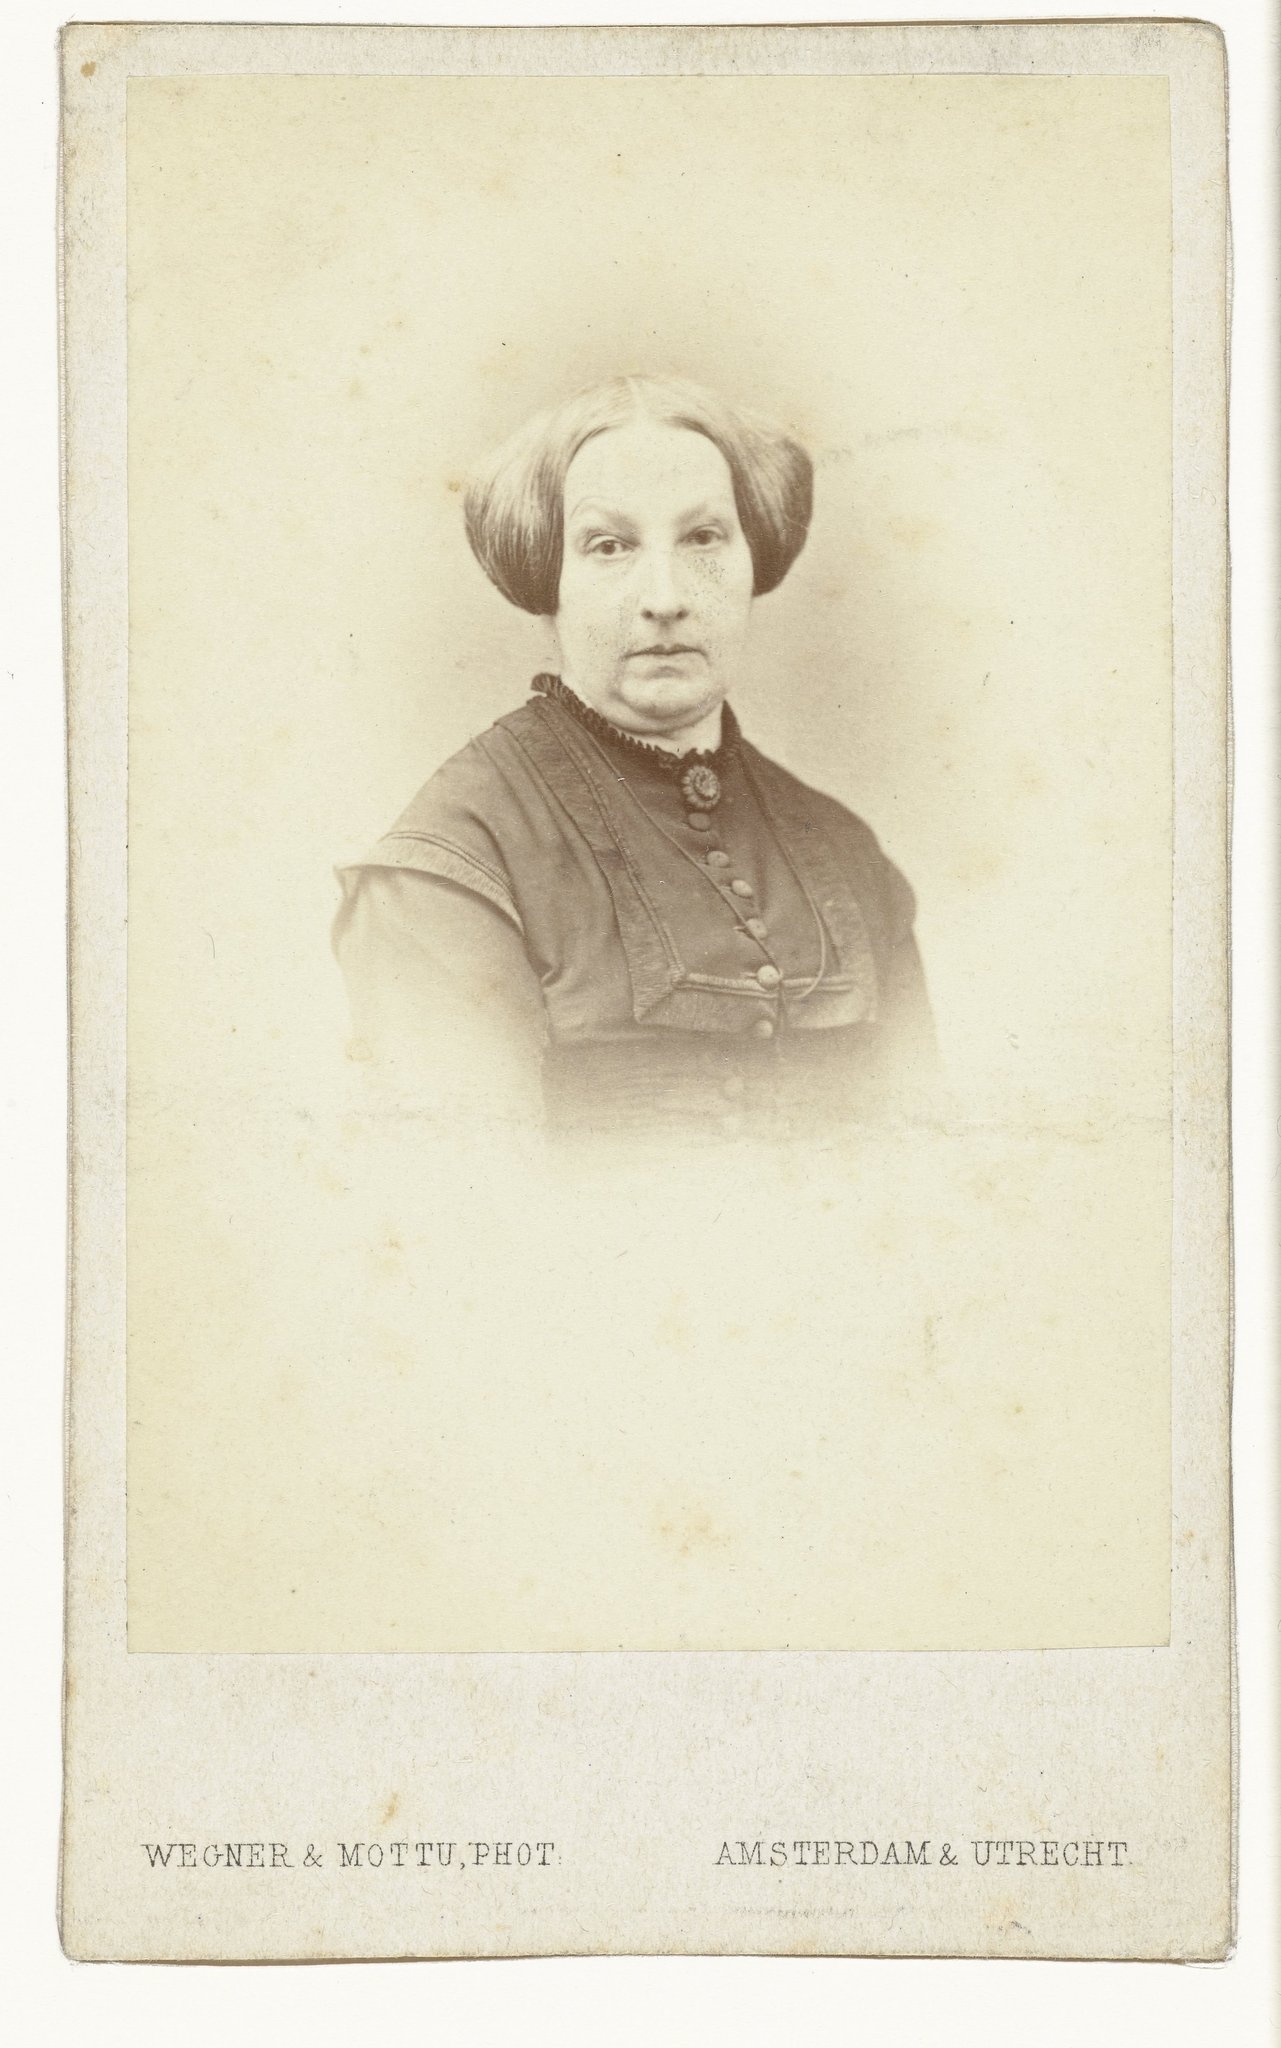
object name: photograph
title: Tante Cato van Braam-Baud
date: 1862-1880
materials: cardboard, paper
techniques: albumen print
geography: amsterdam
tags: historical persons - bb - woman, netherlands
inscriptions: name: ‘Photogr Atelier Wegner & Mottu Kalverstraat over de Heyligenweg D.26 Amsterdam/ Leidsche straatweg Buiten Cathrynen Utrecht’